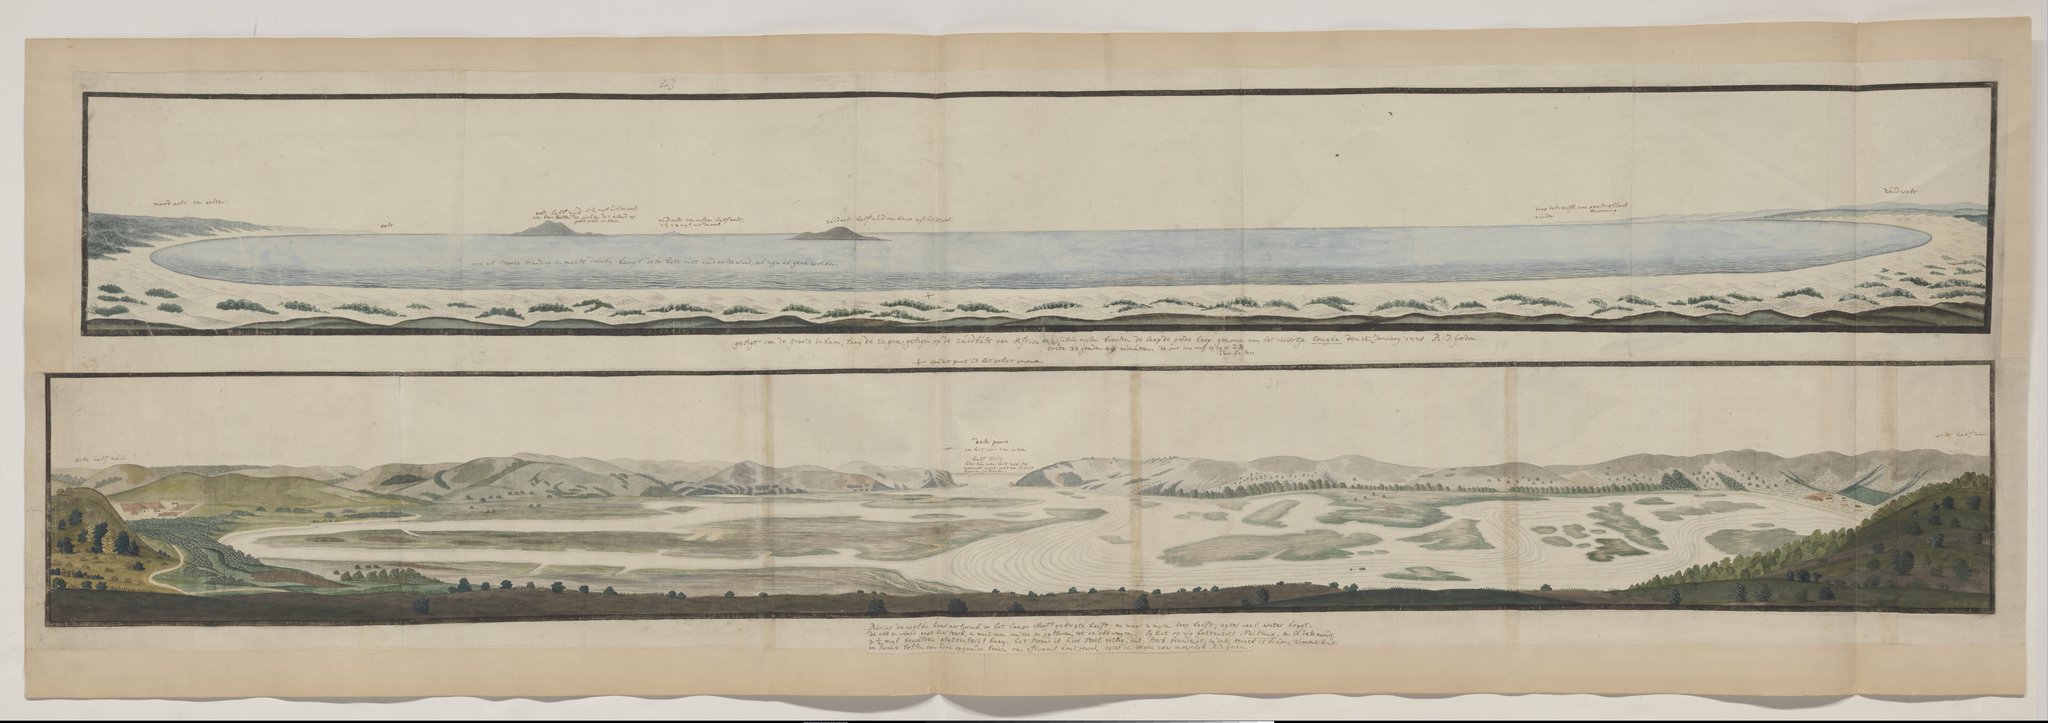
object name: panorama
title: Panorama of the Knysna River and the defile through which it flows into the sea.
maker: robert jacob gordon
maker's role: draughtsman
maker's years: 1743-1795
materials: ink, paper, pencil, watercolor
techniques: brush, pen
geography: cape province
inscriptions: annotation, signature: ‘R:J: Gordon’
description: Oorspronkelijk in omslag van roodkleurig halfleer en roodgemarmerd plat, dorso met ribben en goudopdruk; 71 x 99 x 6 cm.